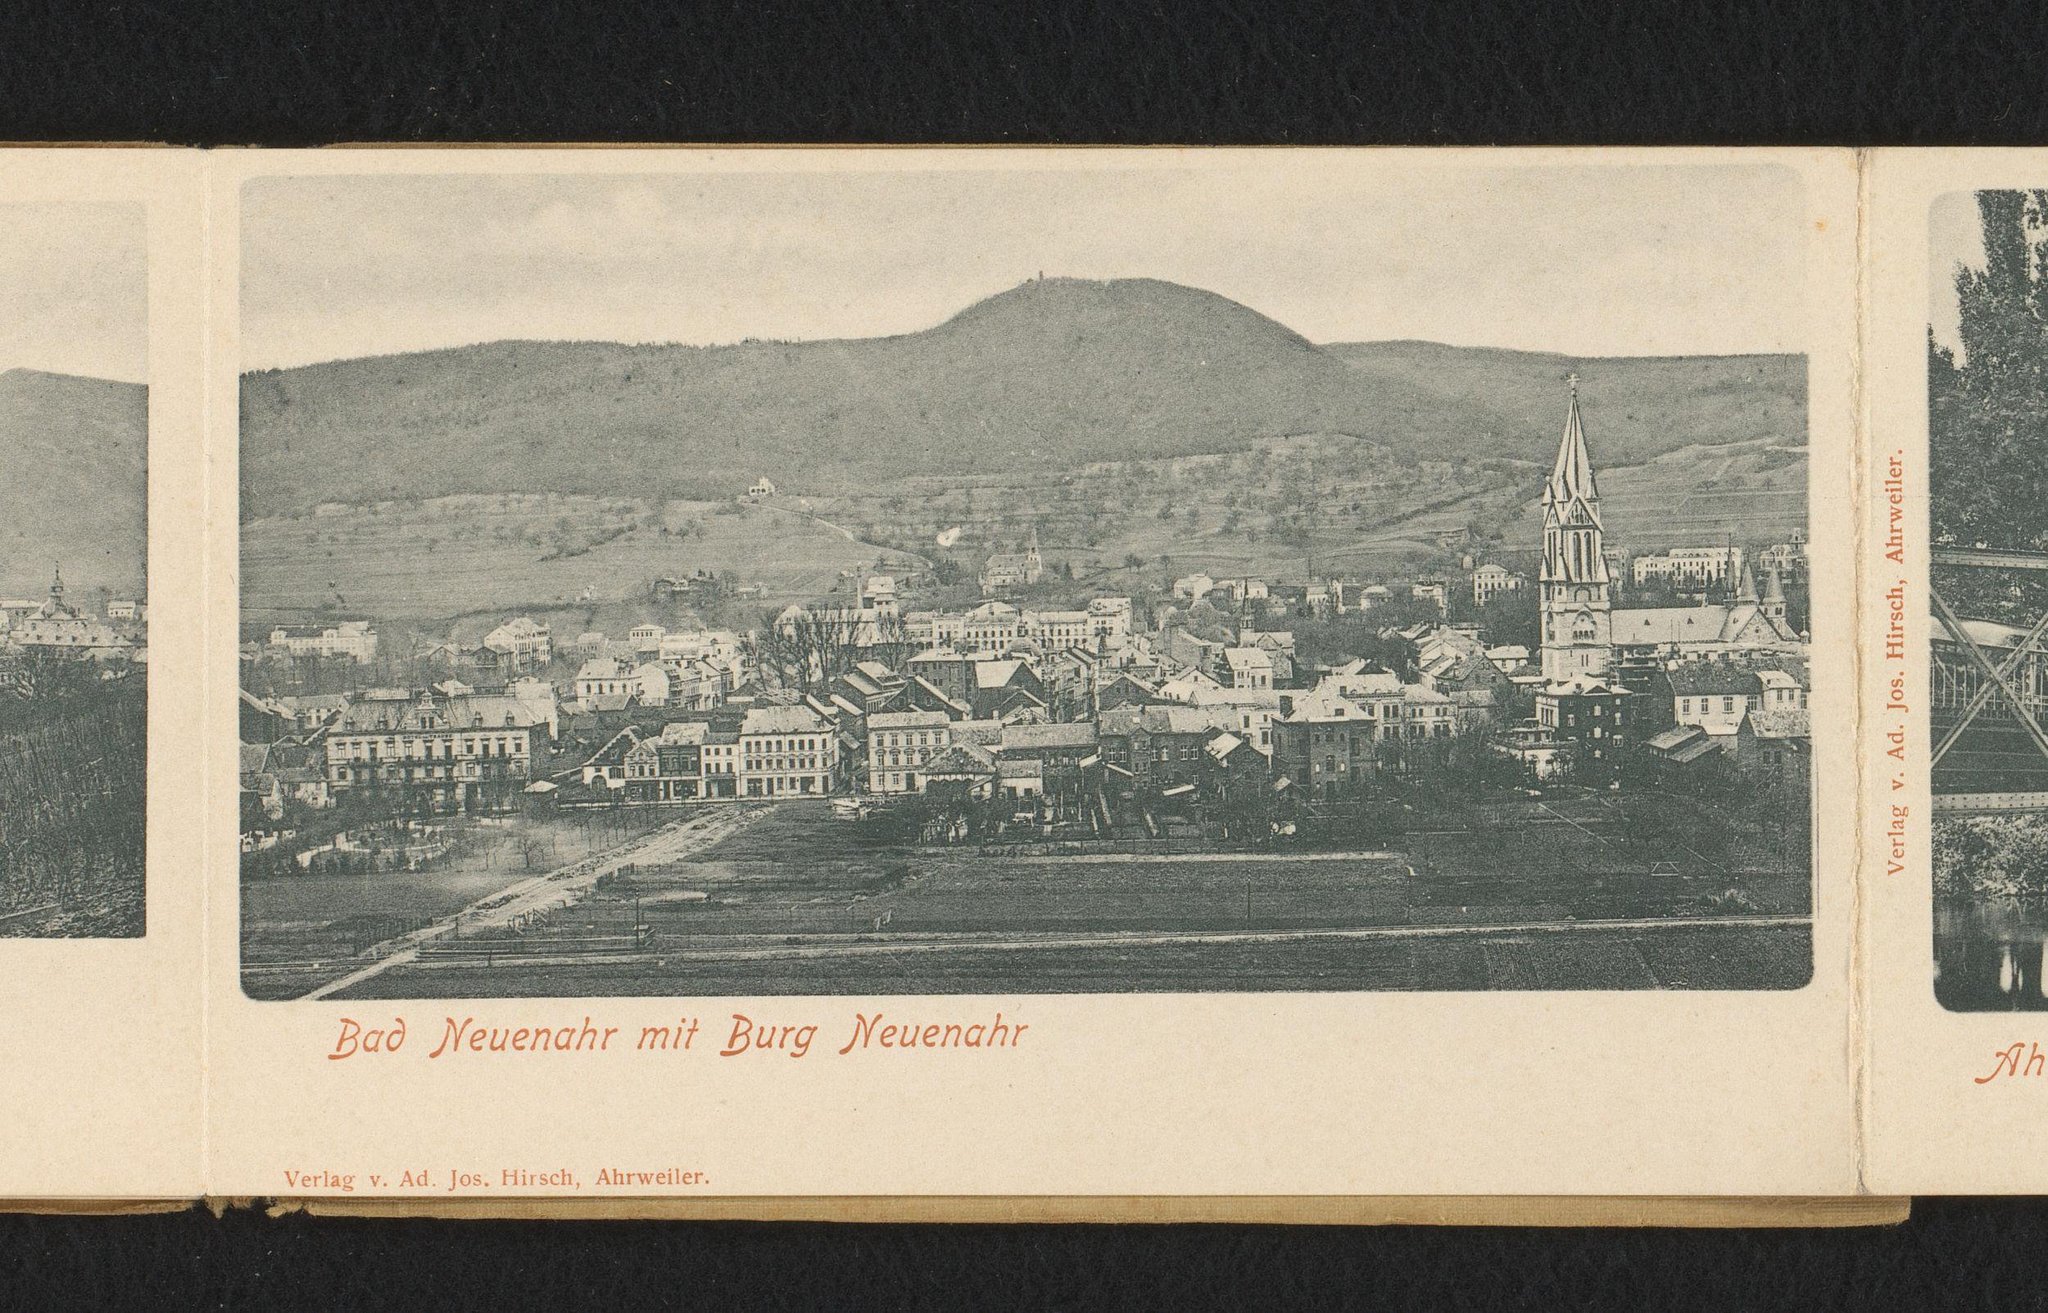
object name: ansichtkaart, prentbriefkaart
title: Bad Neuenahr met Burg Neuenahr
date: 1885-1903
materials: cardboard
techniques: photograph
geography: ahrweiler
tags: city-view, and landscape with man-made constructions, castle, church (exterior), mountains